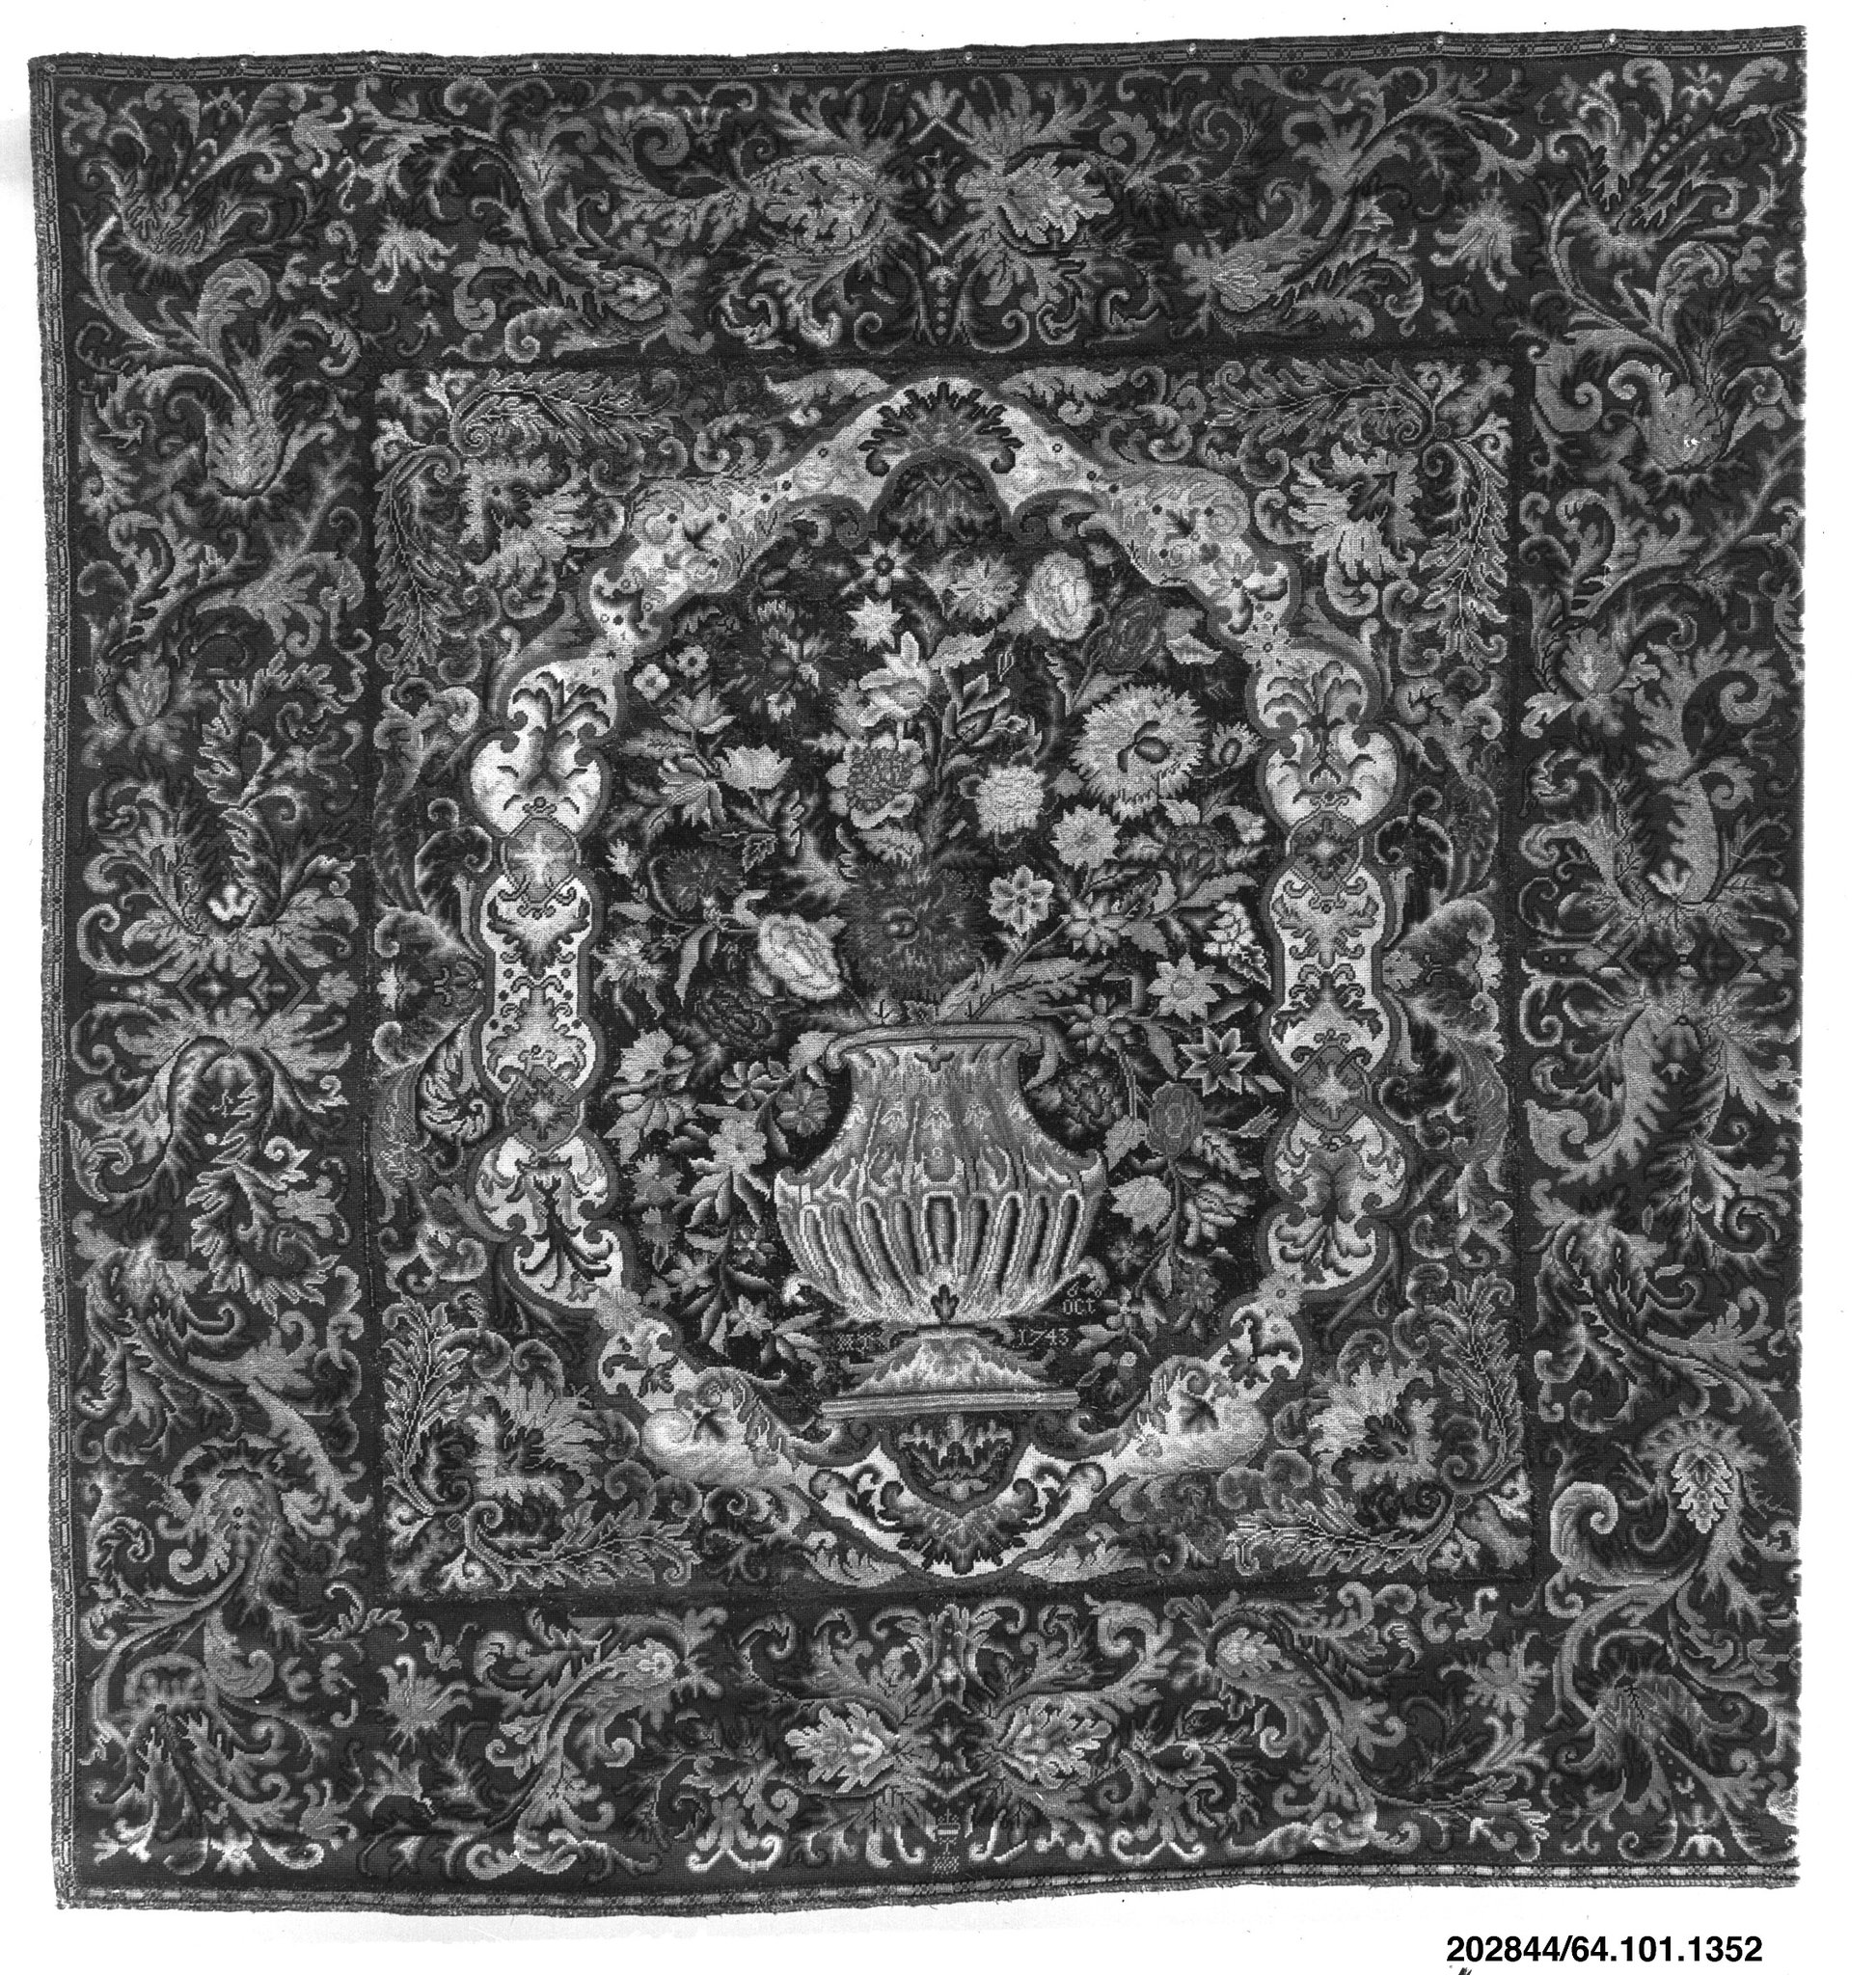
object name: carpet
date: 1743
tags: flowers